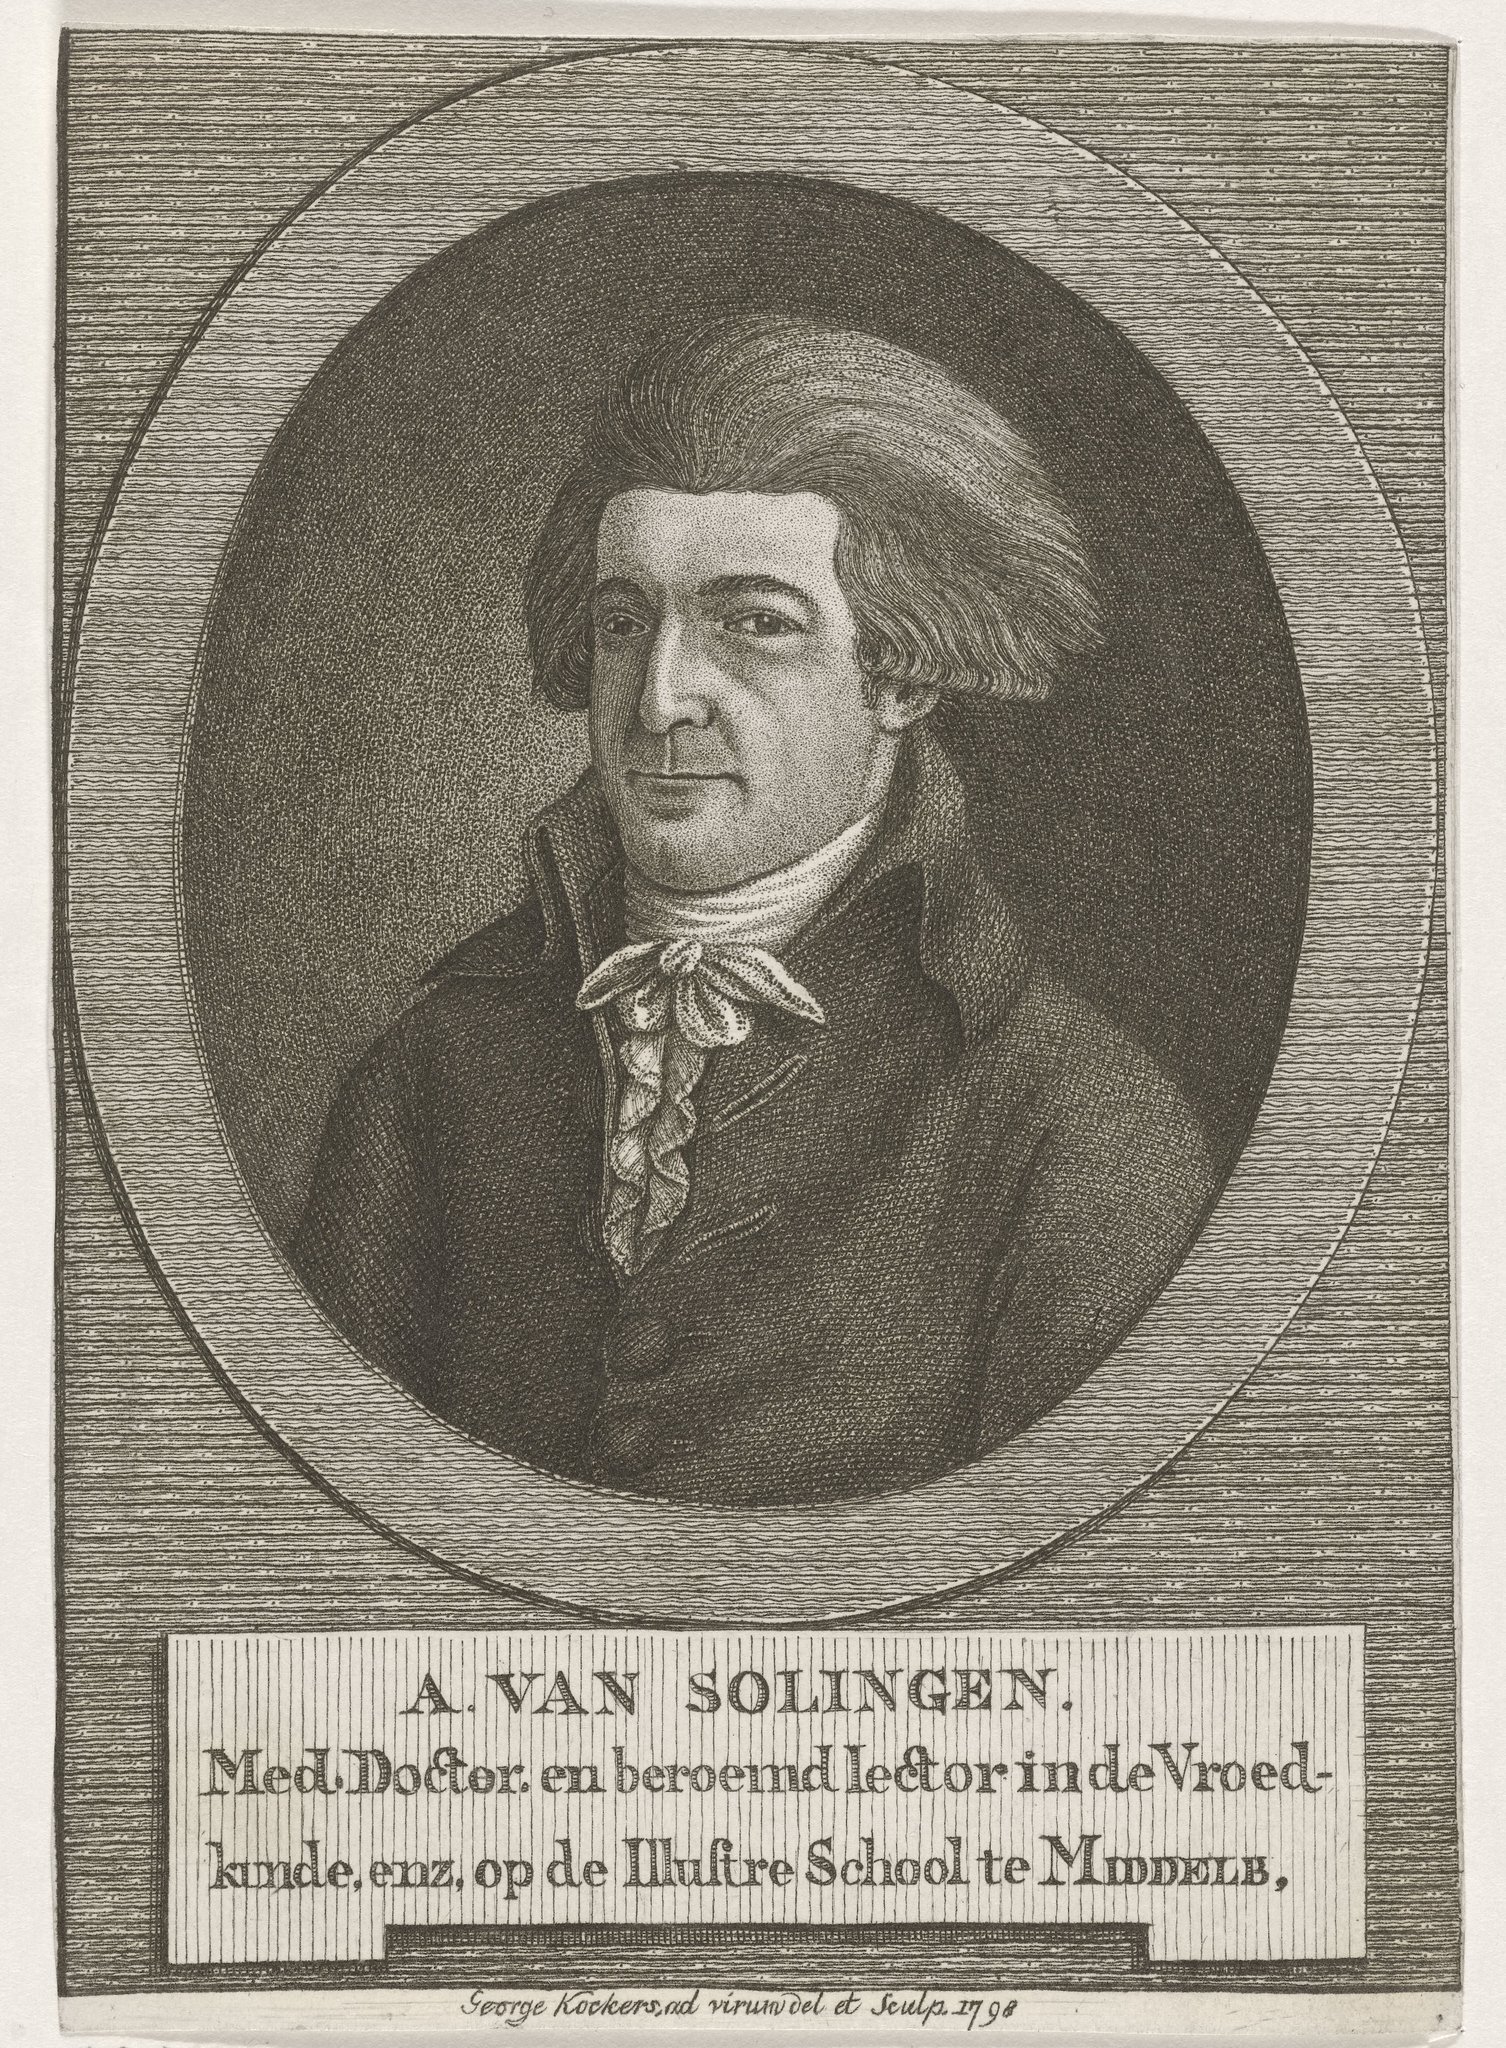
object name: print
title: Portret van Adriaan van Solingen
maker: george kockers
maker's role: goldsmith, print maker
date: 1798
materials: paper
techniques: engraving, etching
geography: middelburg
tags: middelburg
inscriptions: collector's mark: Lugt 2228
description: Portretbuste in ovale omlijsting naar links van Adriaan van Solingen, gynaecoloog en professor medicijnen te Middelburg. Onder het portret een drieregelig onderschrift.